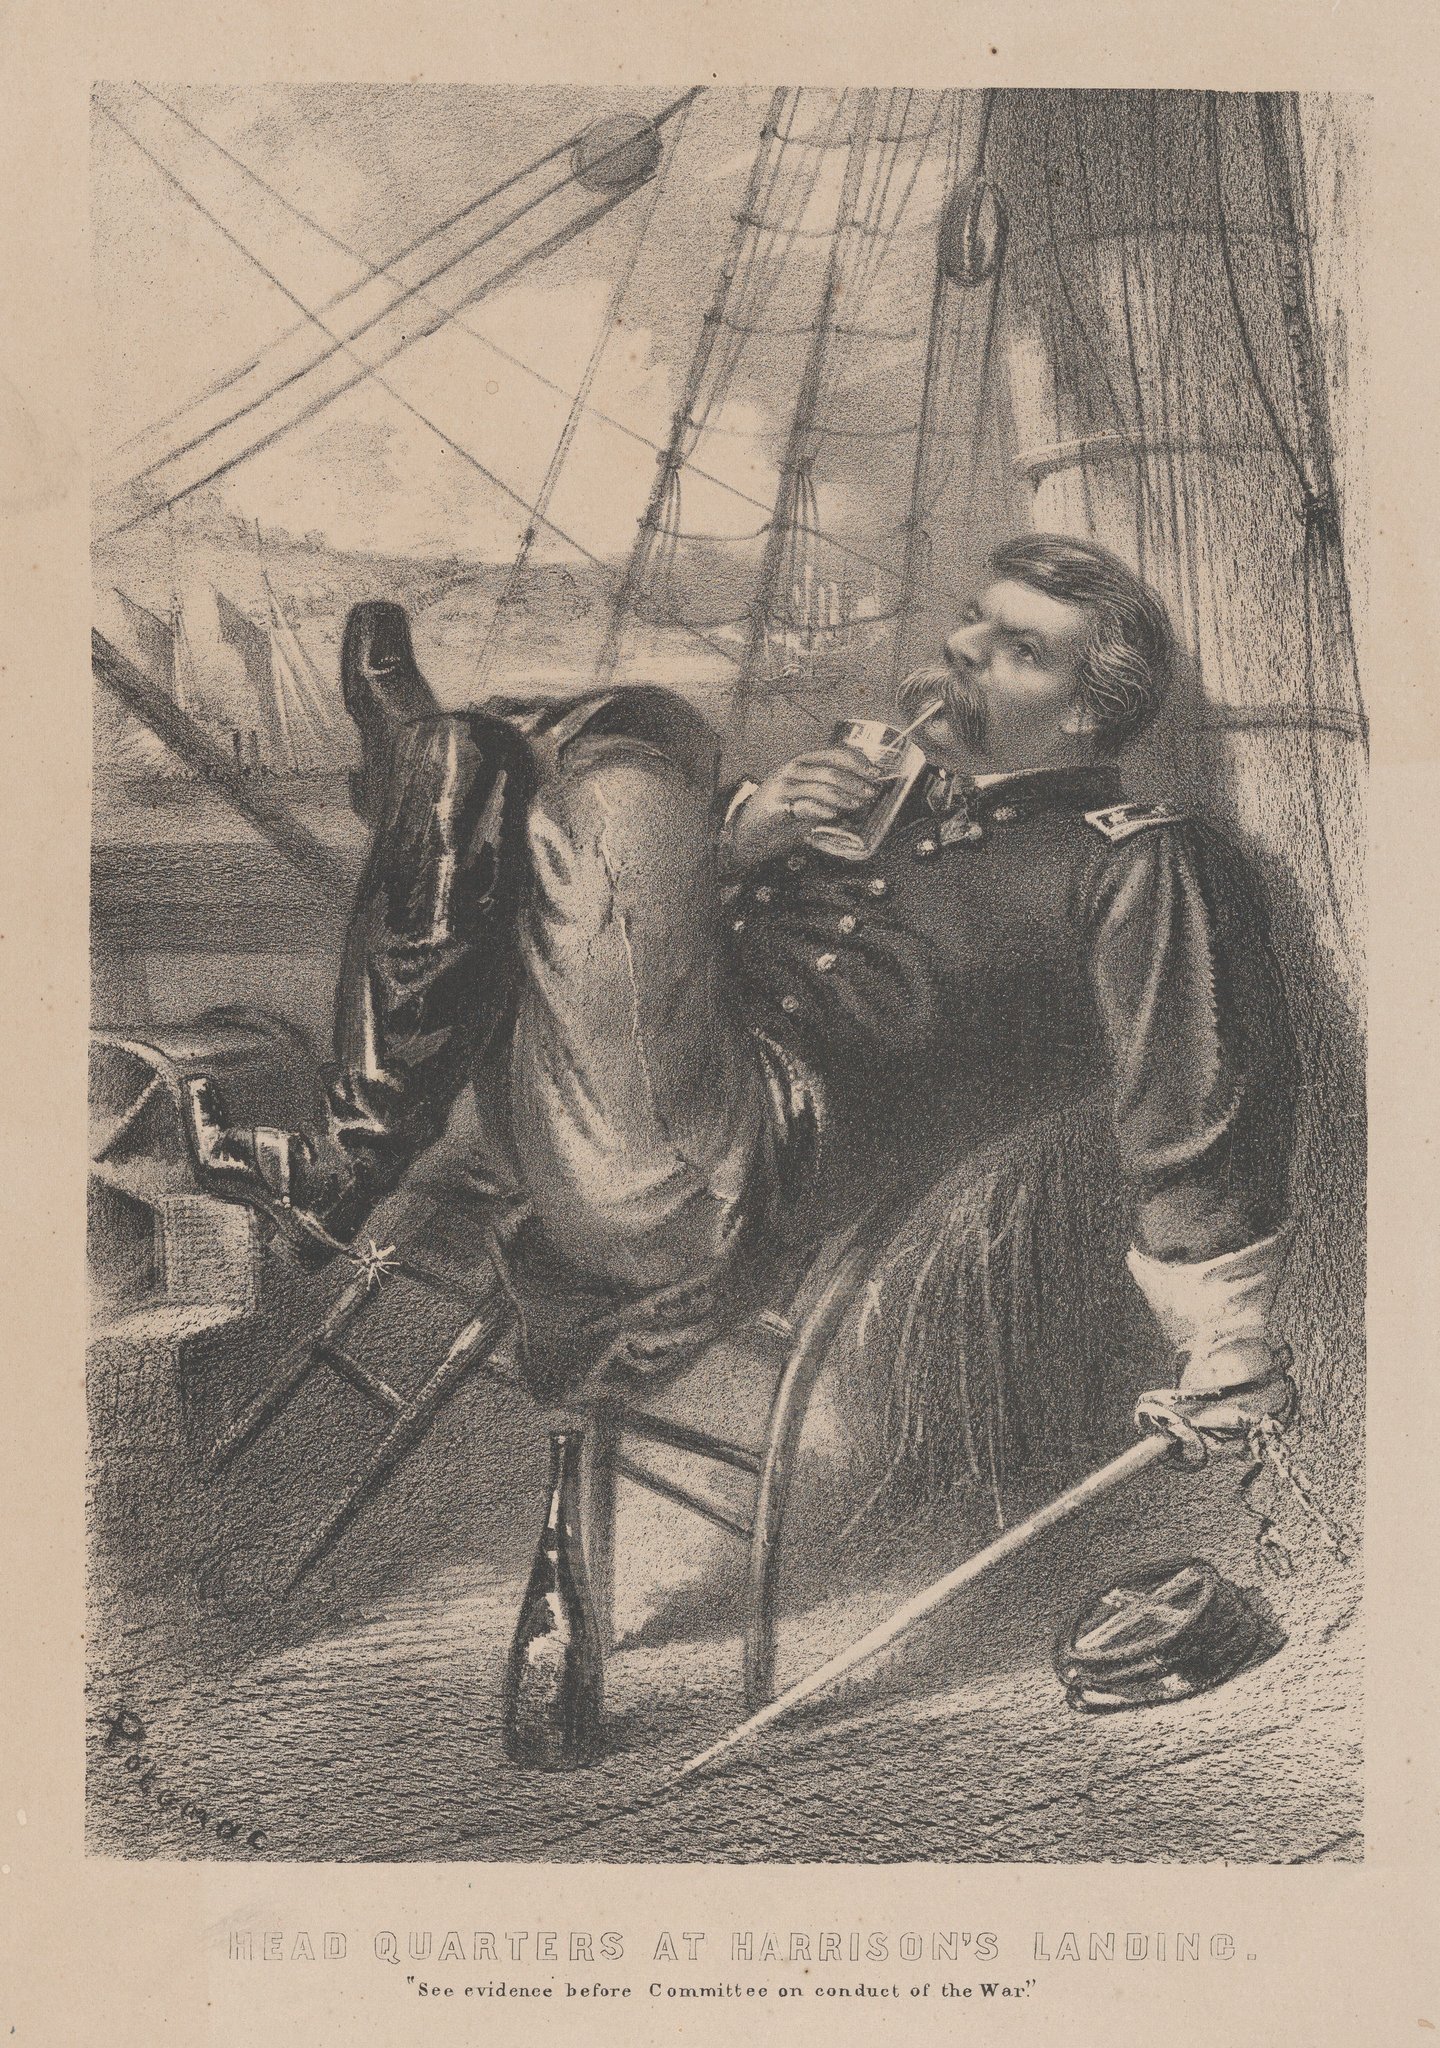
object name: print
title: Head Quarters at Harrison's Landing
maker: anonymous, american, 19th century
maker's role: artist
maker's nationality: american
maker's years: 1800-1900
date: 1862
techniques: lithograph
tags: soldiers,american civil war,men,drinking